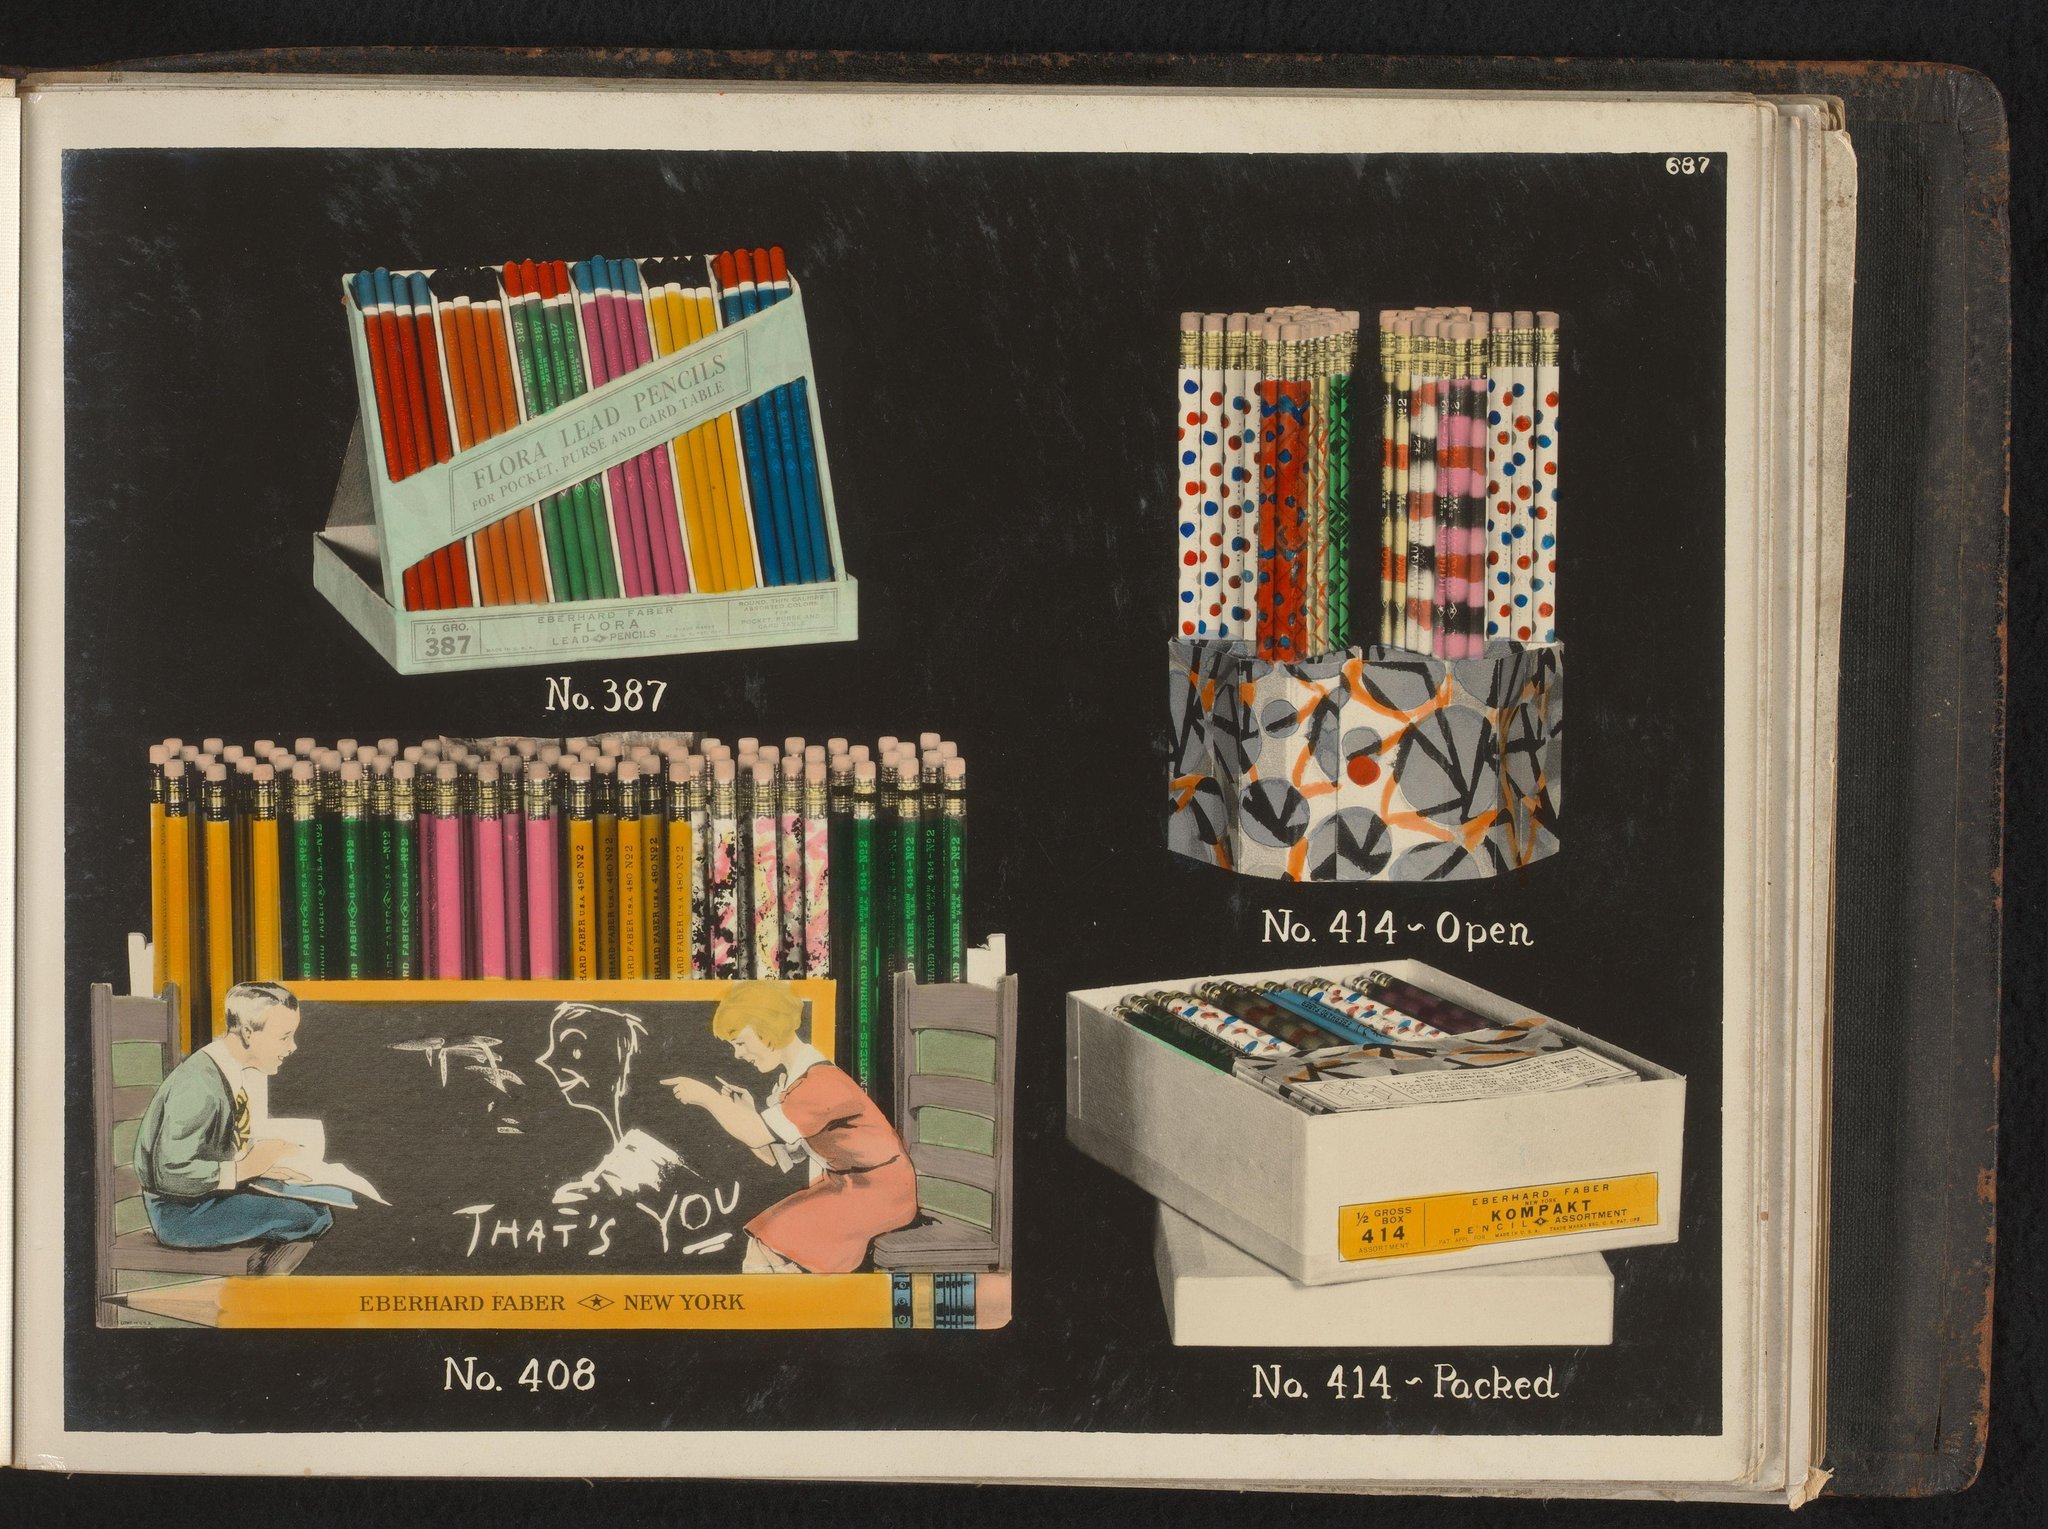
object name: album leaf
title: Standaarden met potloden van Eberhard Faber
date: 1915-1935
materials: paper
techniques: gelatin silver print, hand coloring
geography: springfield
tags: pencil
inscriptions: number: ‘687’, stamp: ‘Paramount/ Commercial Studios/ 145 Chestnut St./ Springfield - Mass.’